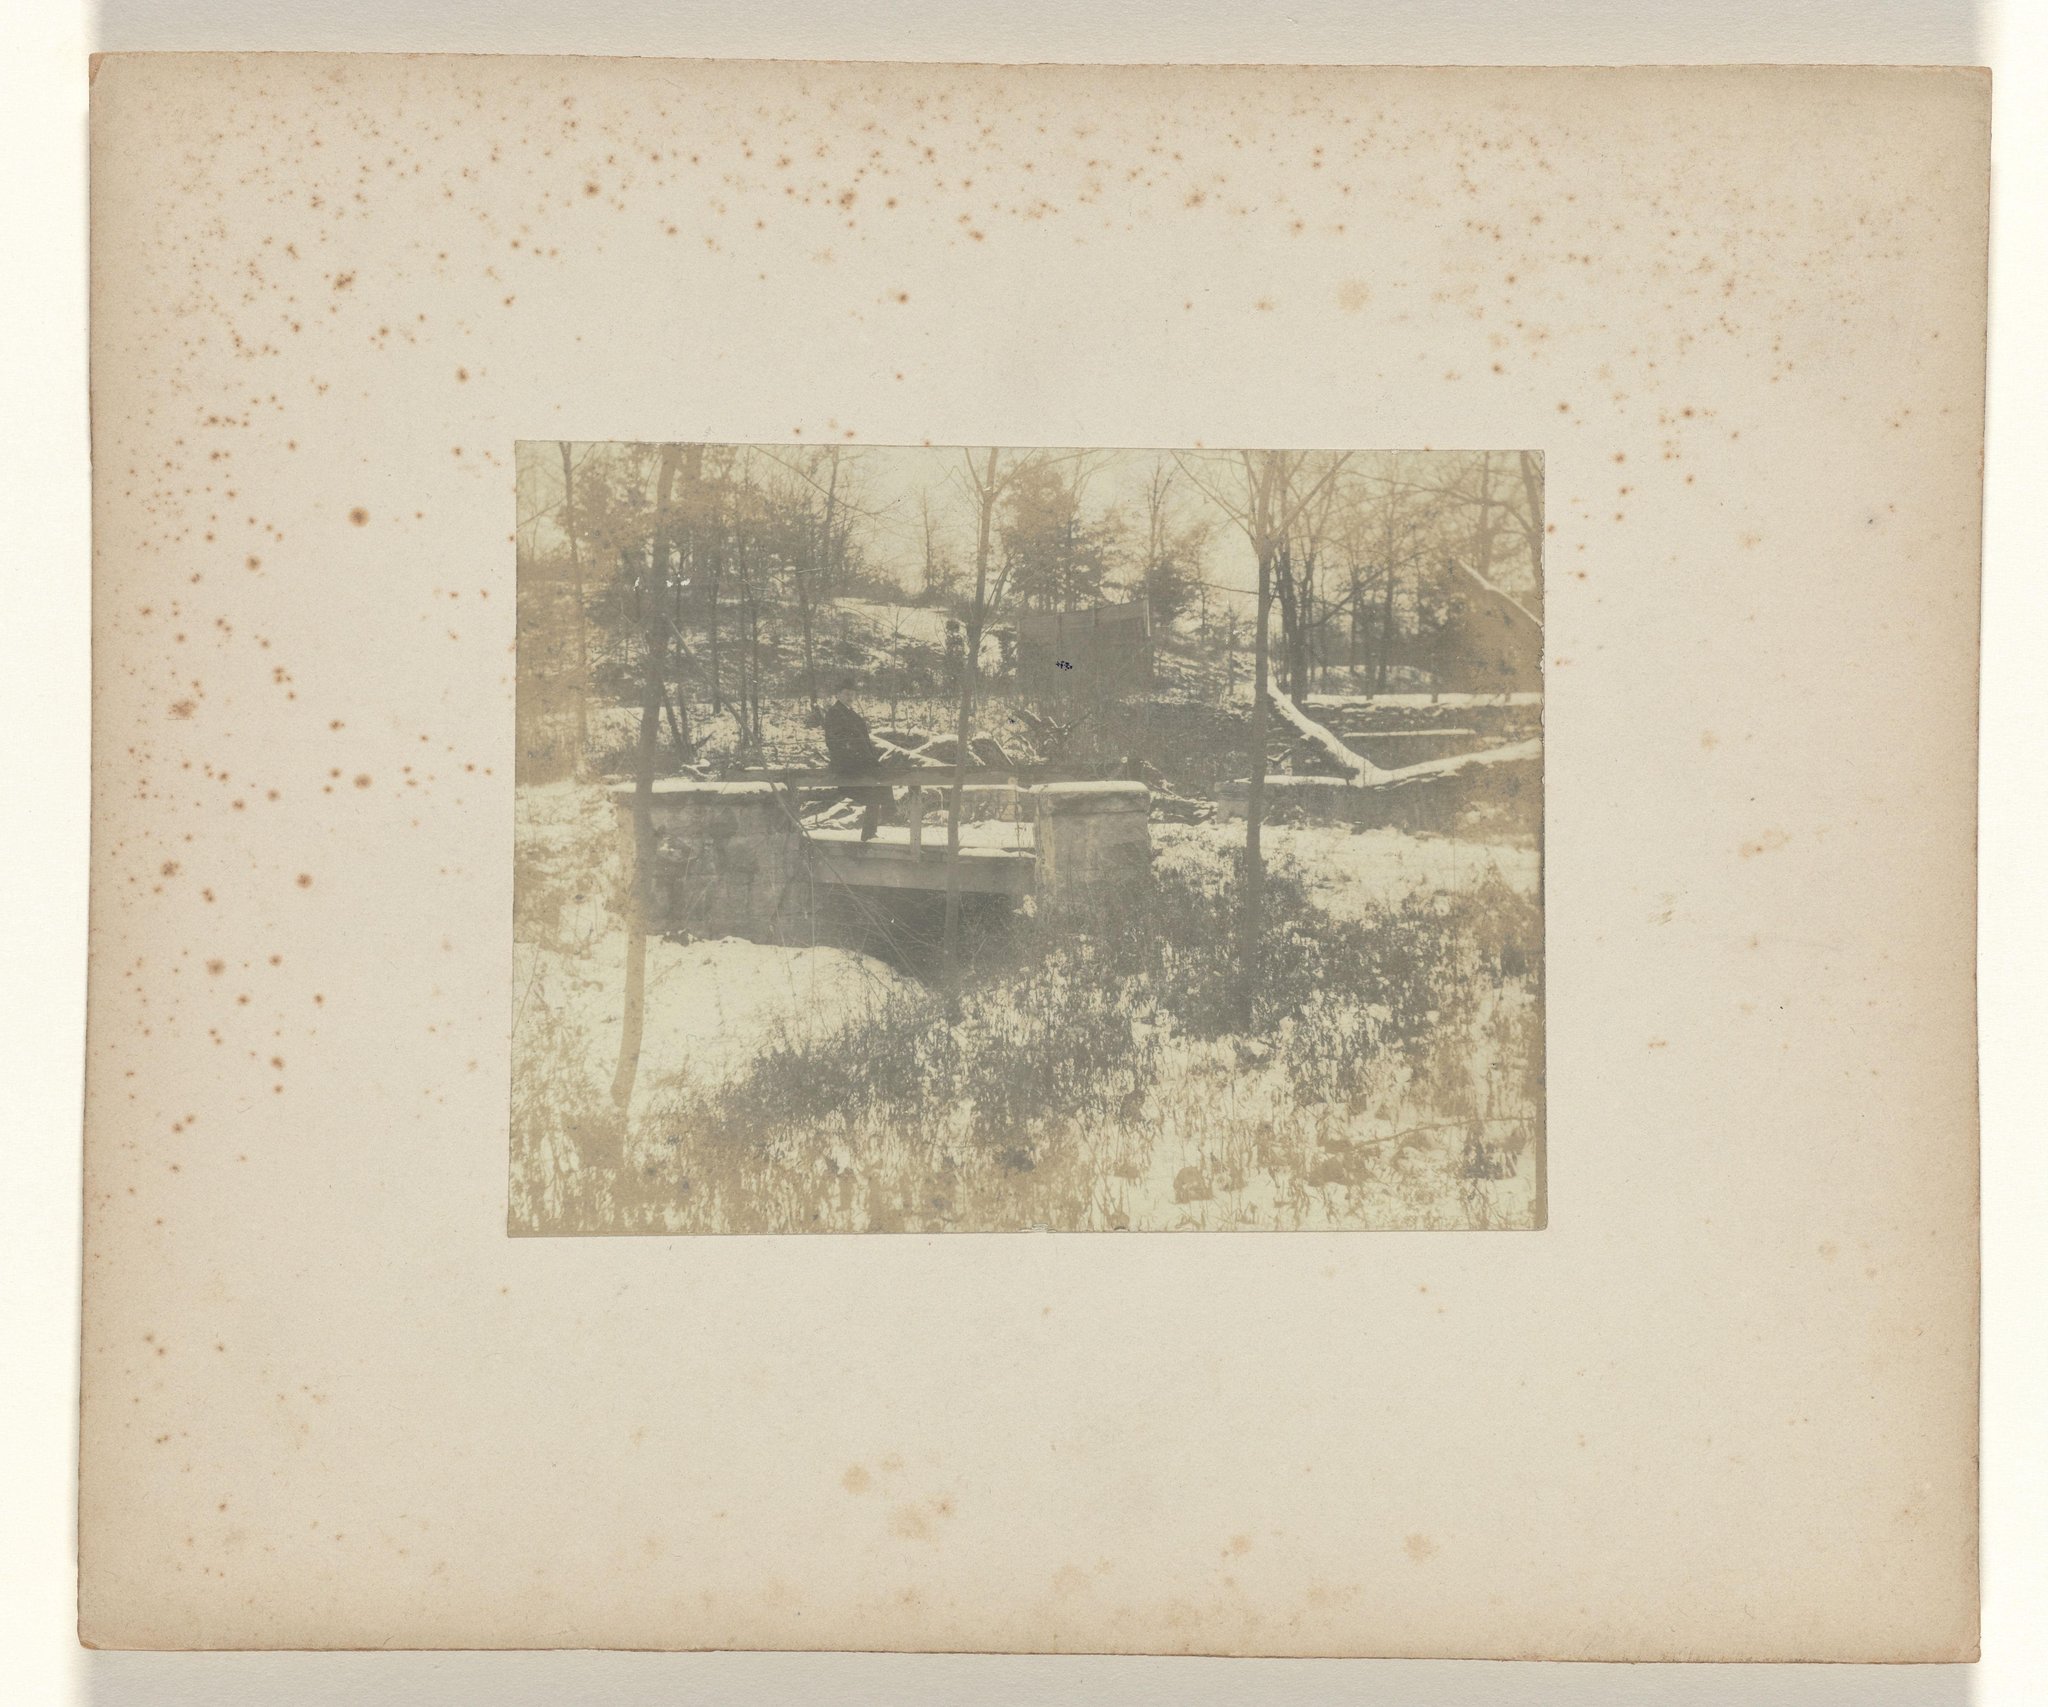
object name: photograph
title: Jan C. Schüller in de Meramec Highlands tijdens de wereldtentoonstelling in St. Louis (Louisiana Purchase Exposition), 1904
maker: Anonymous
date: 1904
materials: cardboard, paper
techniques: gelatin silver print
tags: painter, print maker, jan schüller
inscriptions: annotation: ‘In het Meramec dal // ruïne van een Brug’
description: Jan C. Schüller in de Meramec Highlands tijdens de wereldtentoonstelling in St. Louis (Louisiana Purchase Exposition), 1904.